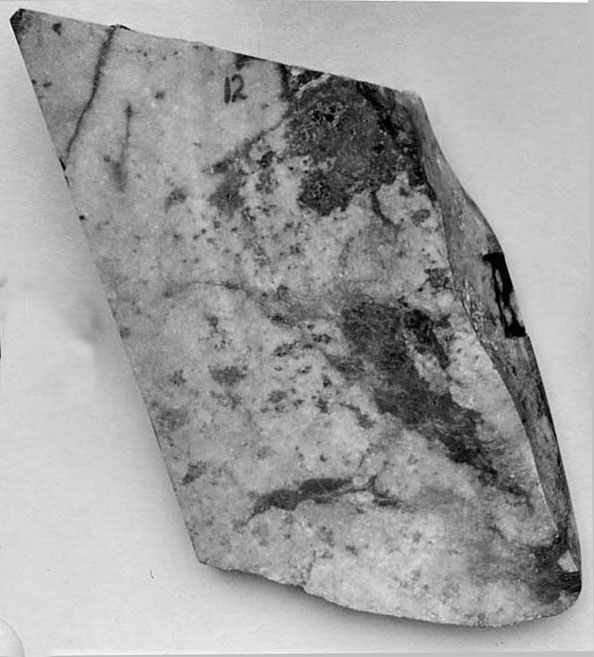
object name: section of boulder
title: Section of a Boulder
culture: burmese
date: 1902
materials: jade